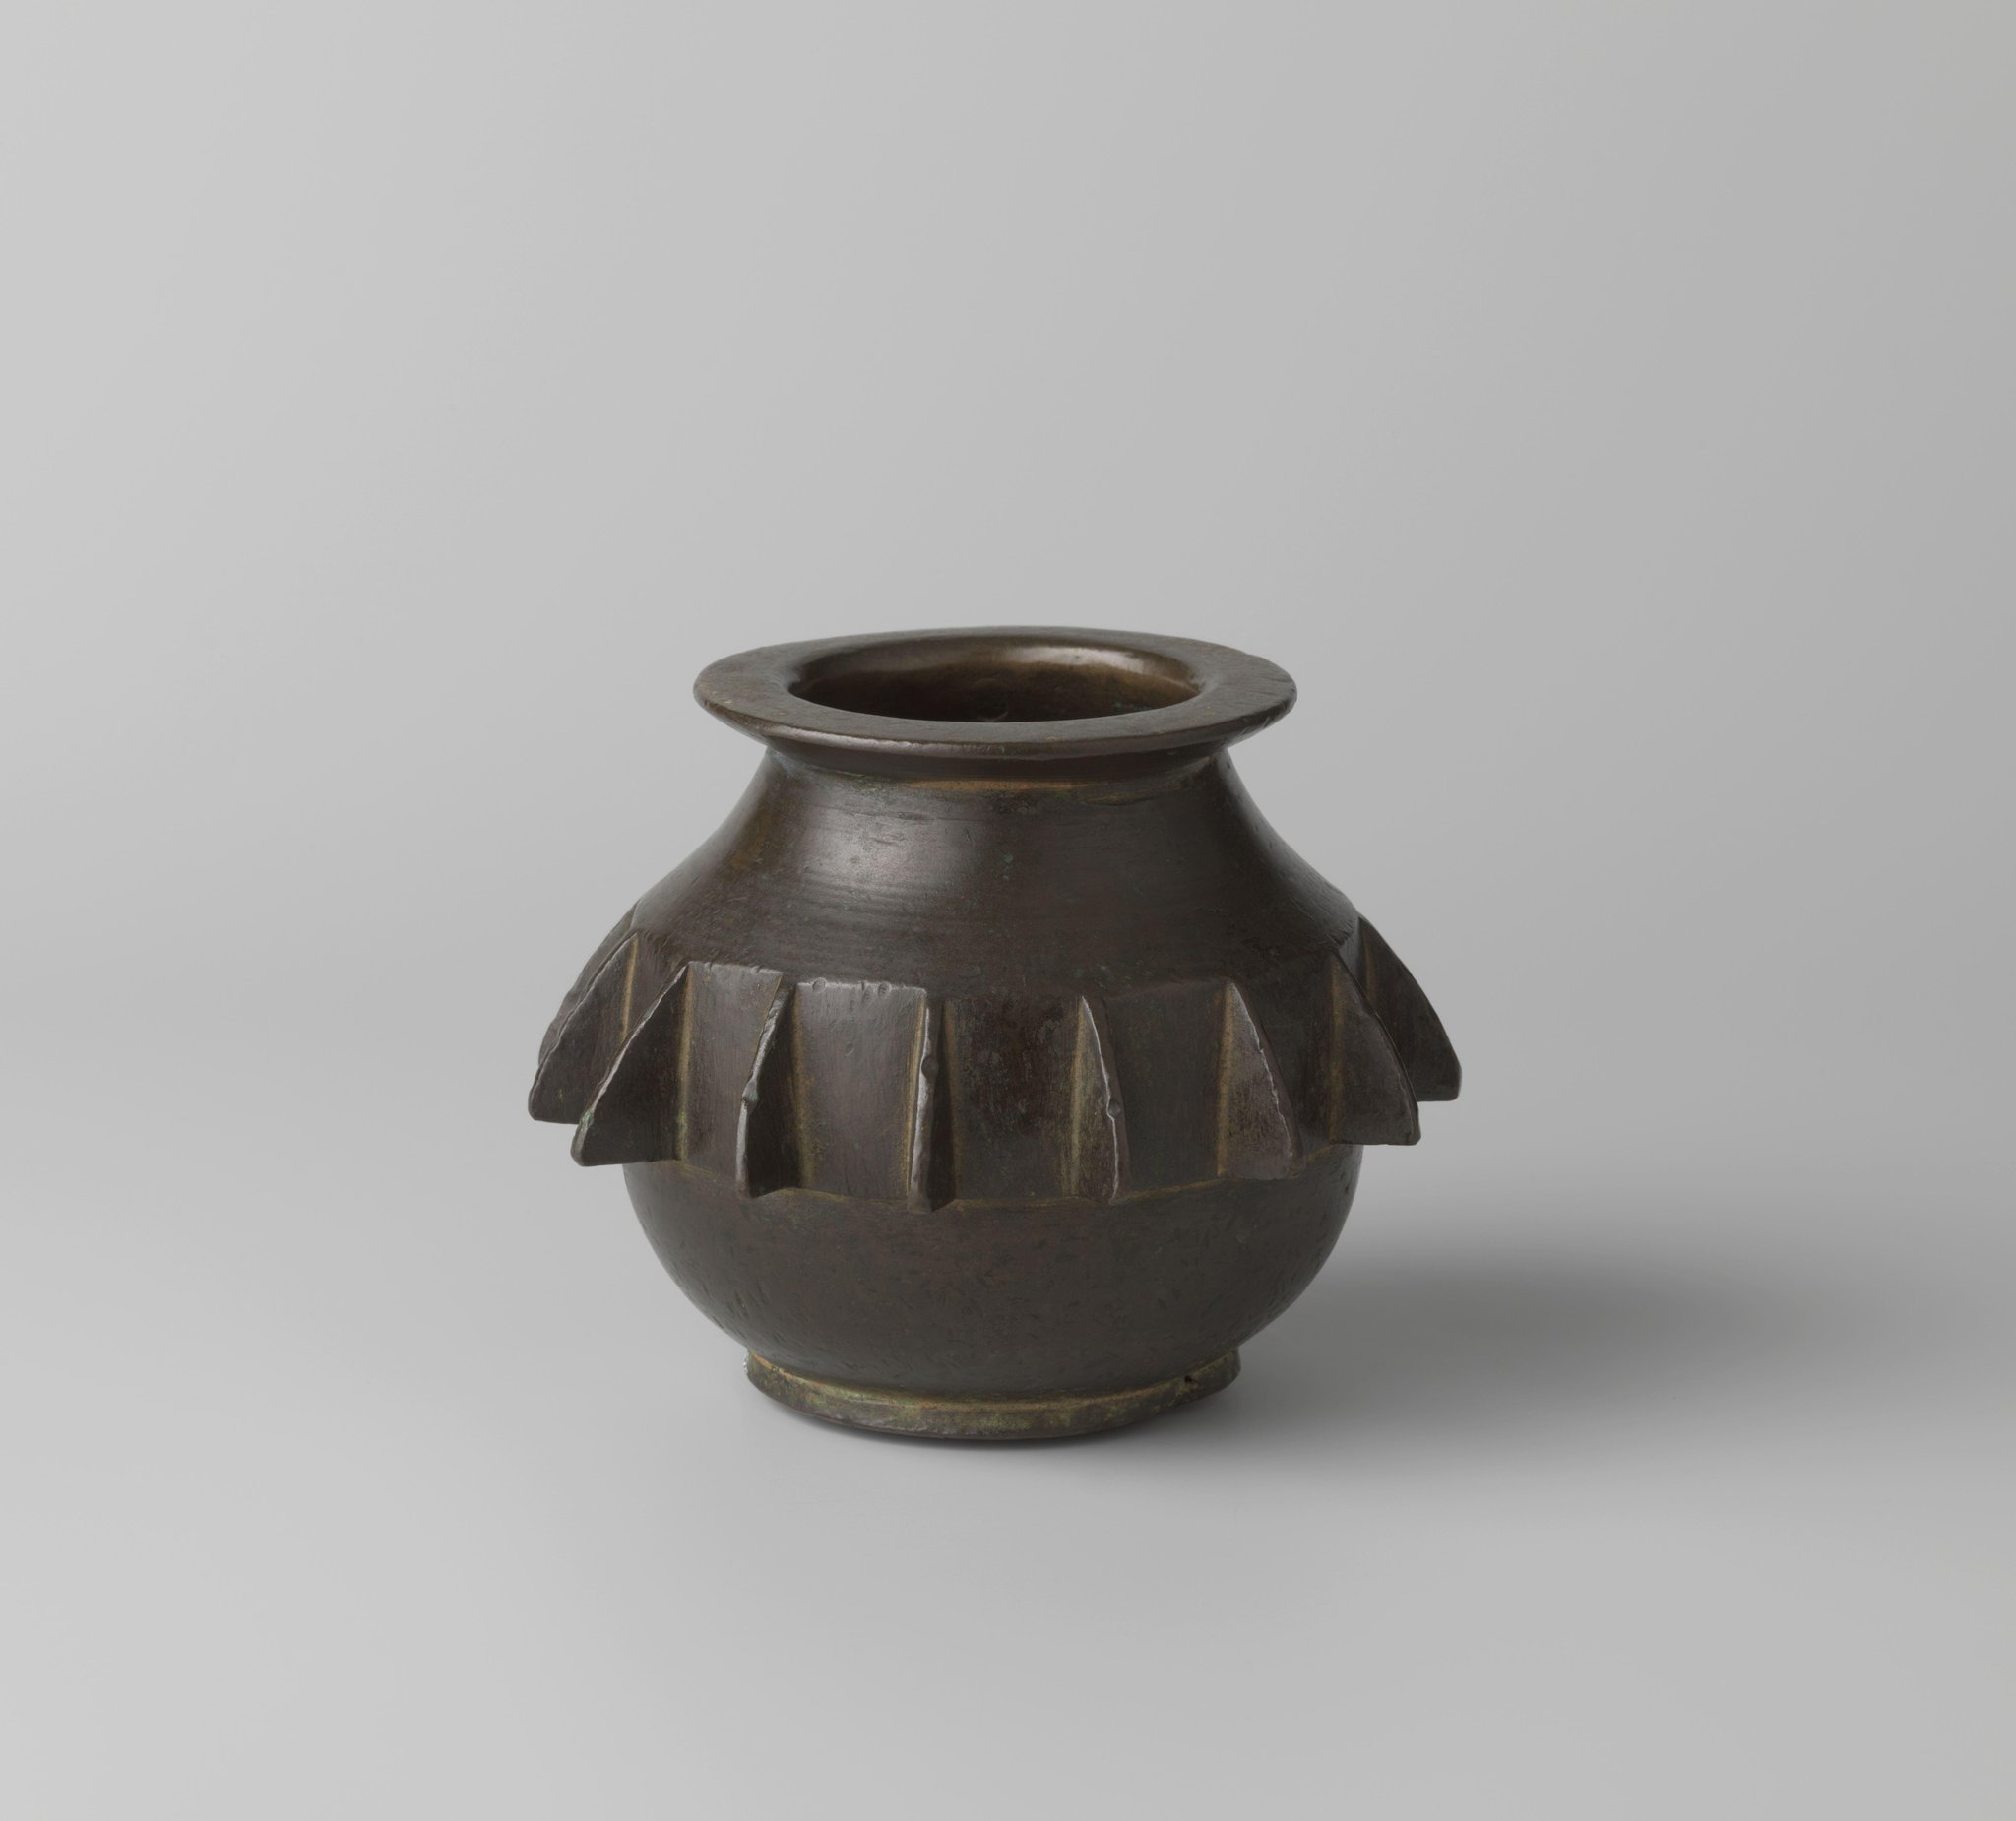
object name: mortar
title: Kogelvormige vijzel, versierd met vinvormige uitsteeksels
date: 1300-1600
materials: bronze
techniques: casting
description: Mortar. Bronze. Spain or Iran, 14th - 16th century (?).